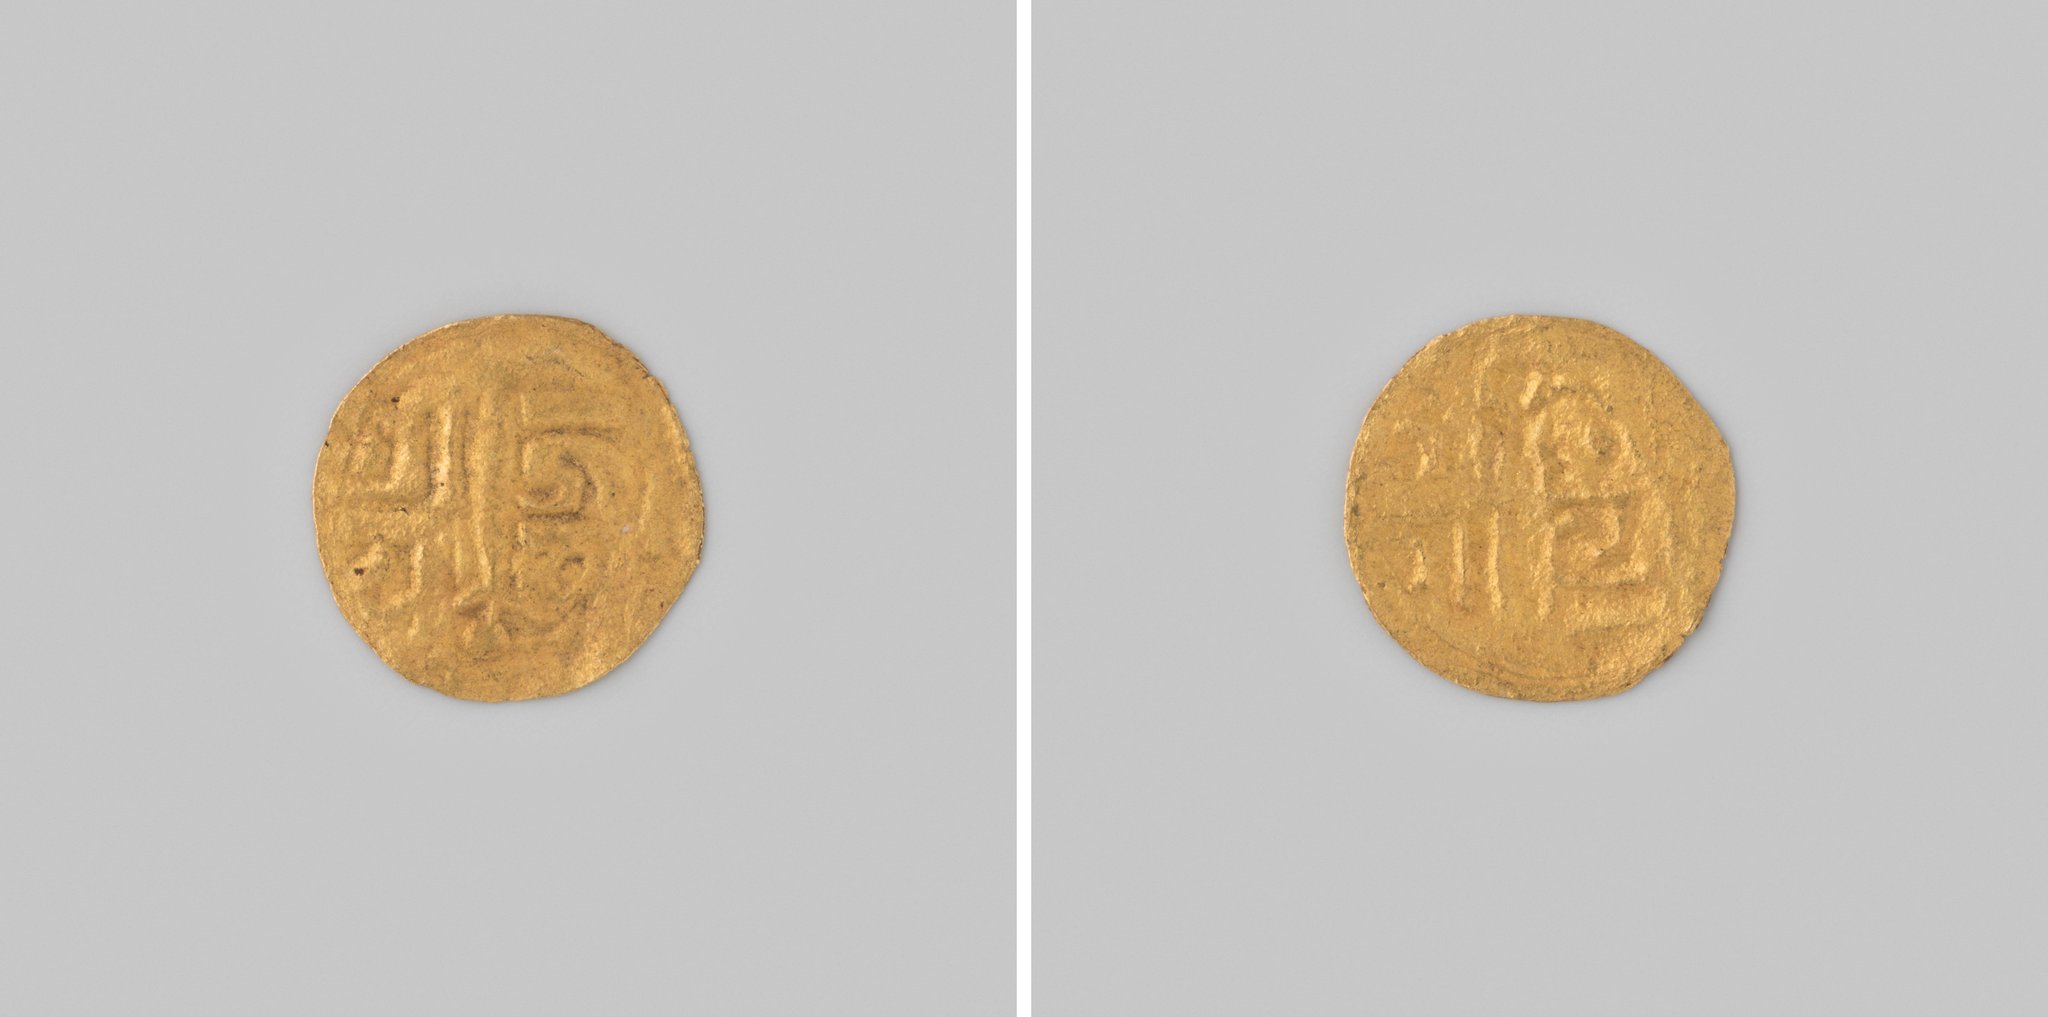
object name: coin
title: 1/8 asrafi uit Nepal van Jaya Prakasa Malla van Katmandu, 1732 - 1768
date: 1732-1768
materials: gold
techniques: striking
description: Gouden munt van 1/64 ashrafi. Voorzijde: stupa, waaromheen tekens in Nagari-schrift. Keerzijde: drietand, waaromheen tekens in Nagari-schrift. Rafelrand.